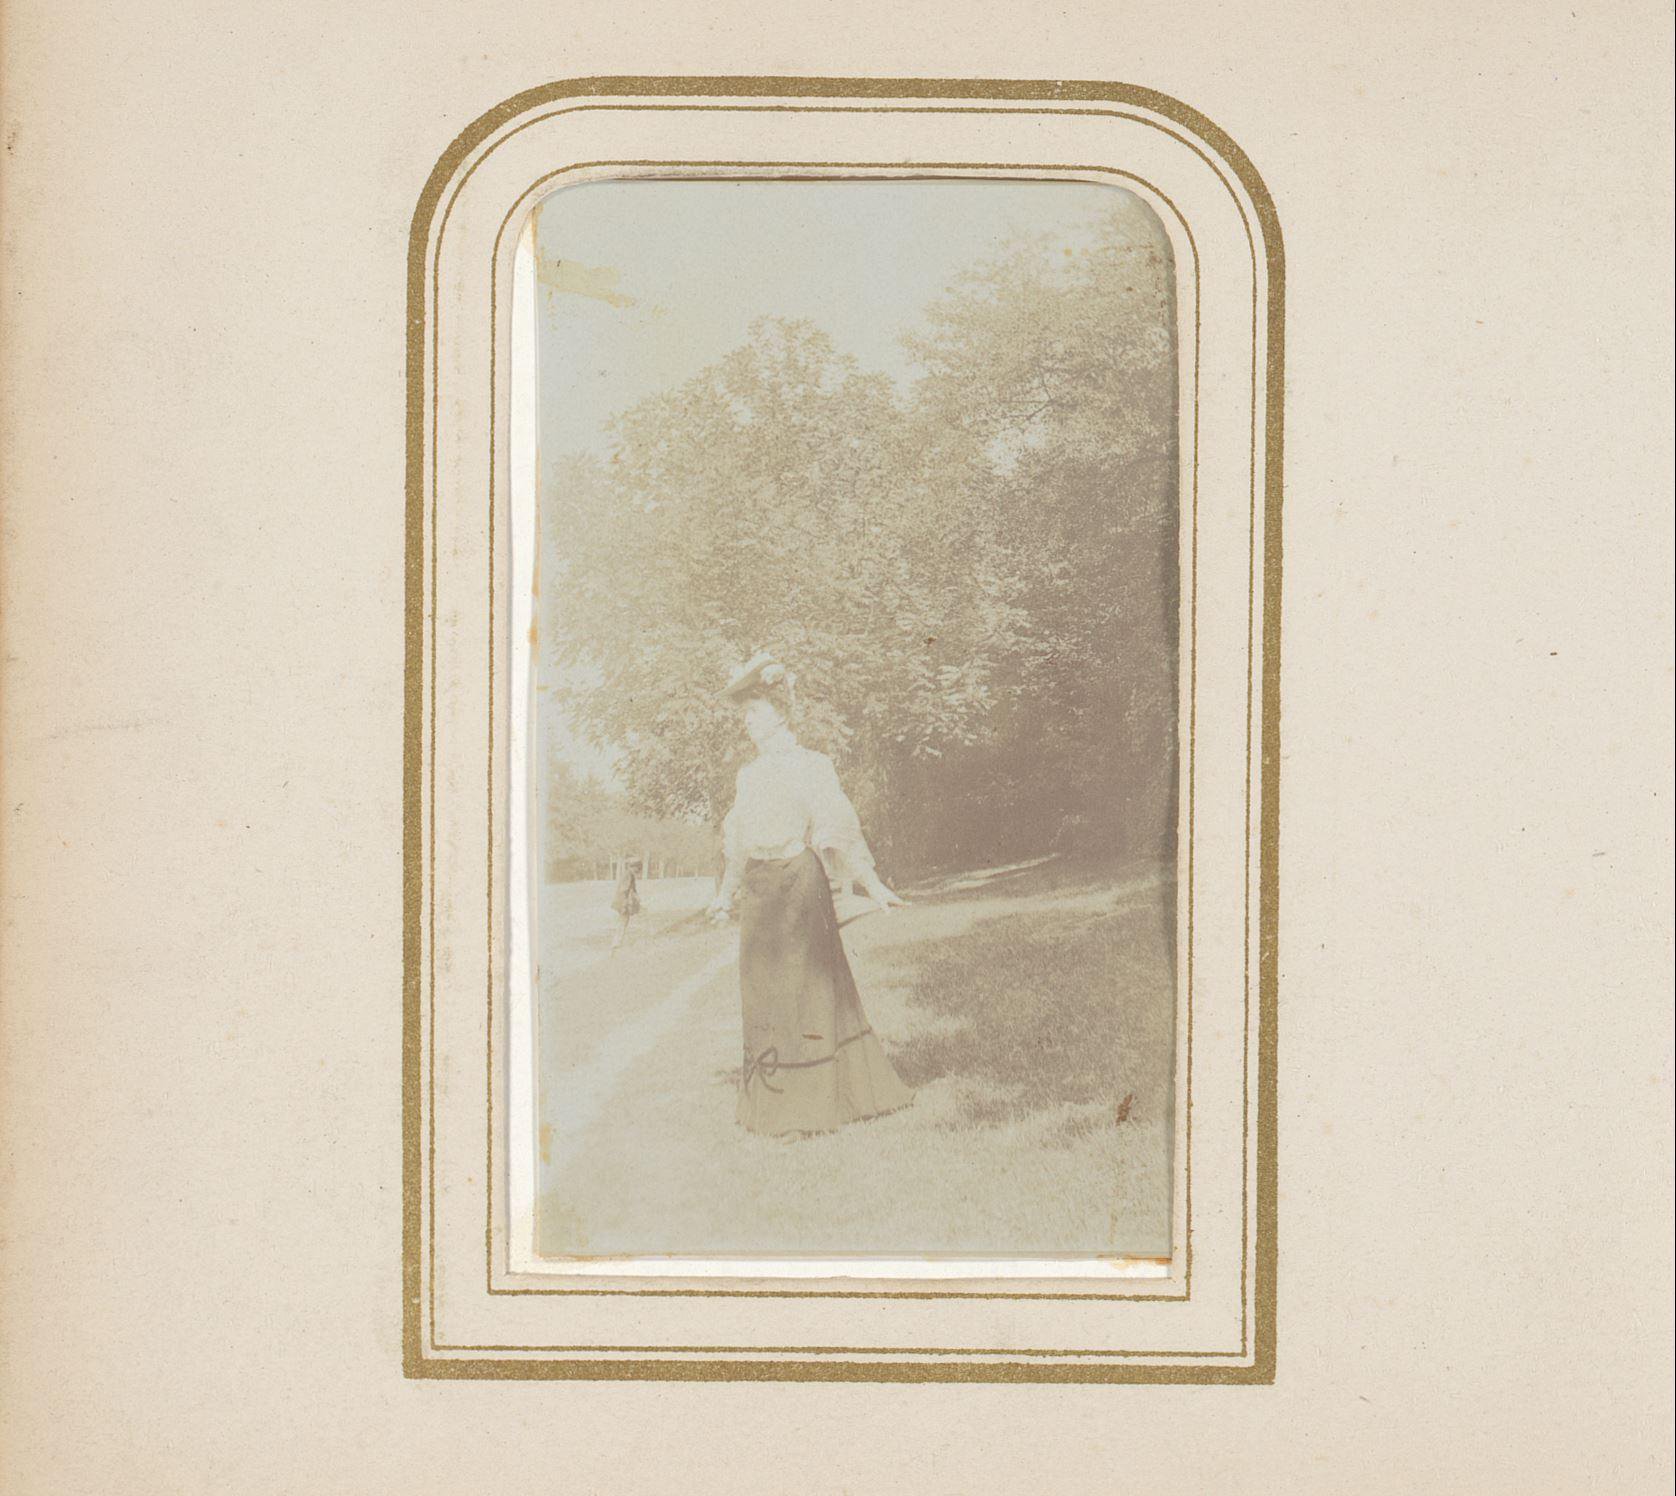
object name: photograph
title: Portret van een vrouw in een tuin of park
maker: Anonymous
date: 1880-1920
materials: cardboard, photographic support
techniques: gelatin silver print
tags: plants (in general), adult woman, historical persons, standing figure - aa - female human figure